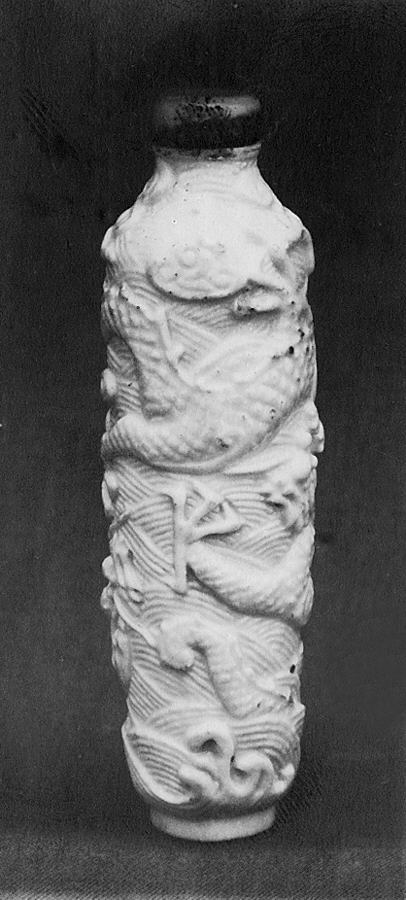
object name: snuff bottle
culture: chinese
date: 1796-1820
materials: porcelain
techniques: molding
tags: dragons